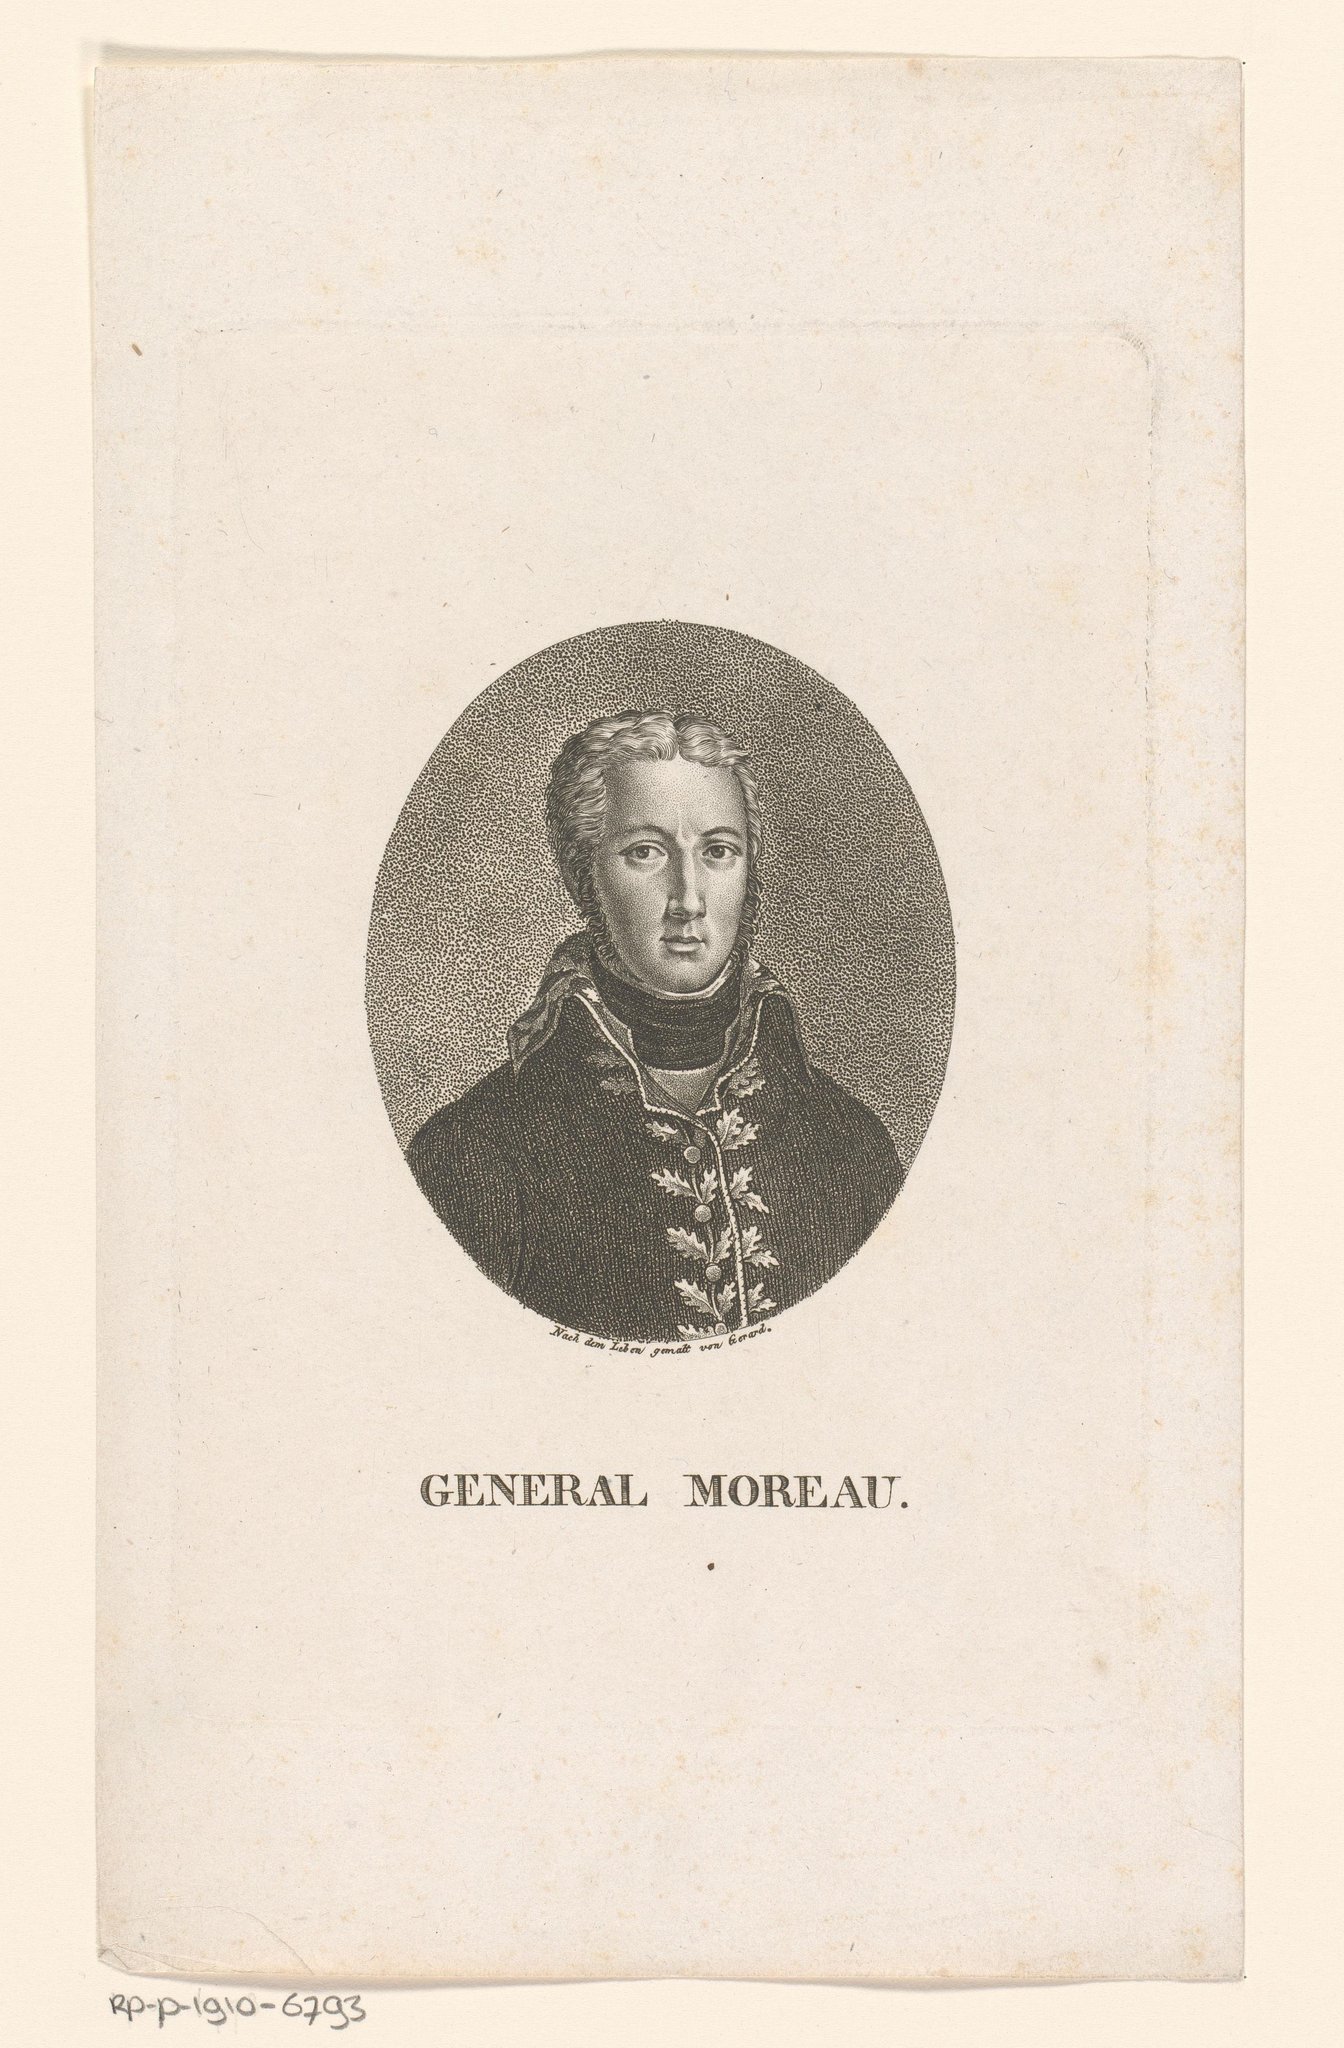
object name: print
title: General Moreau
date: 1790-1850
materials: paper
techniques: engraving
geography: germany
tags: commander-in-chief, general, marshal, historical persons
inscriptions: collector's mark: Lugt 2228